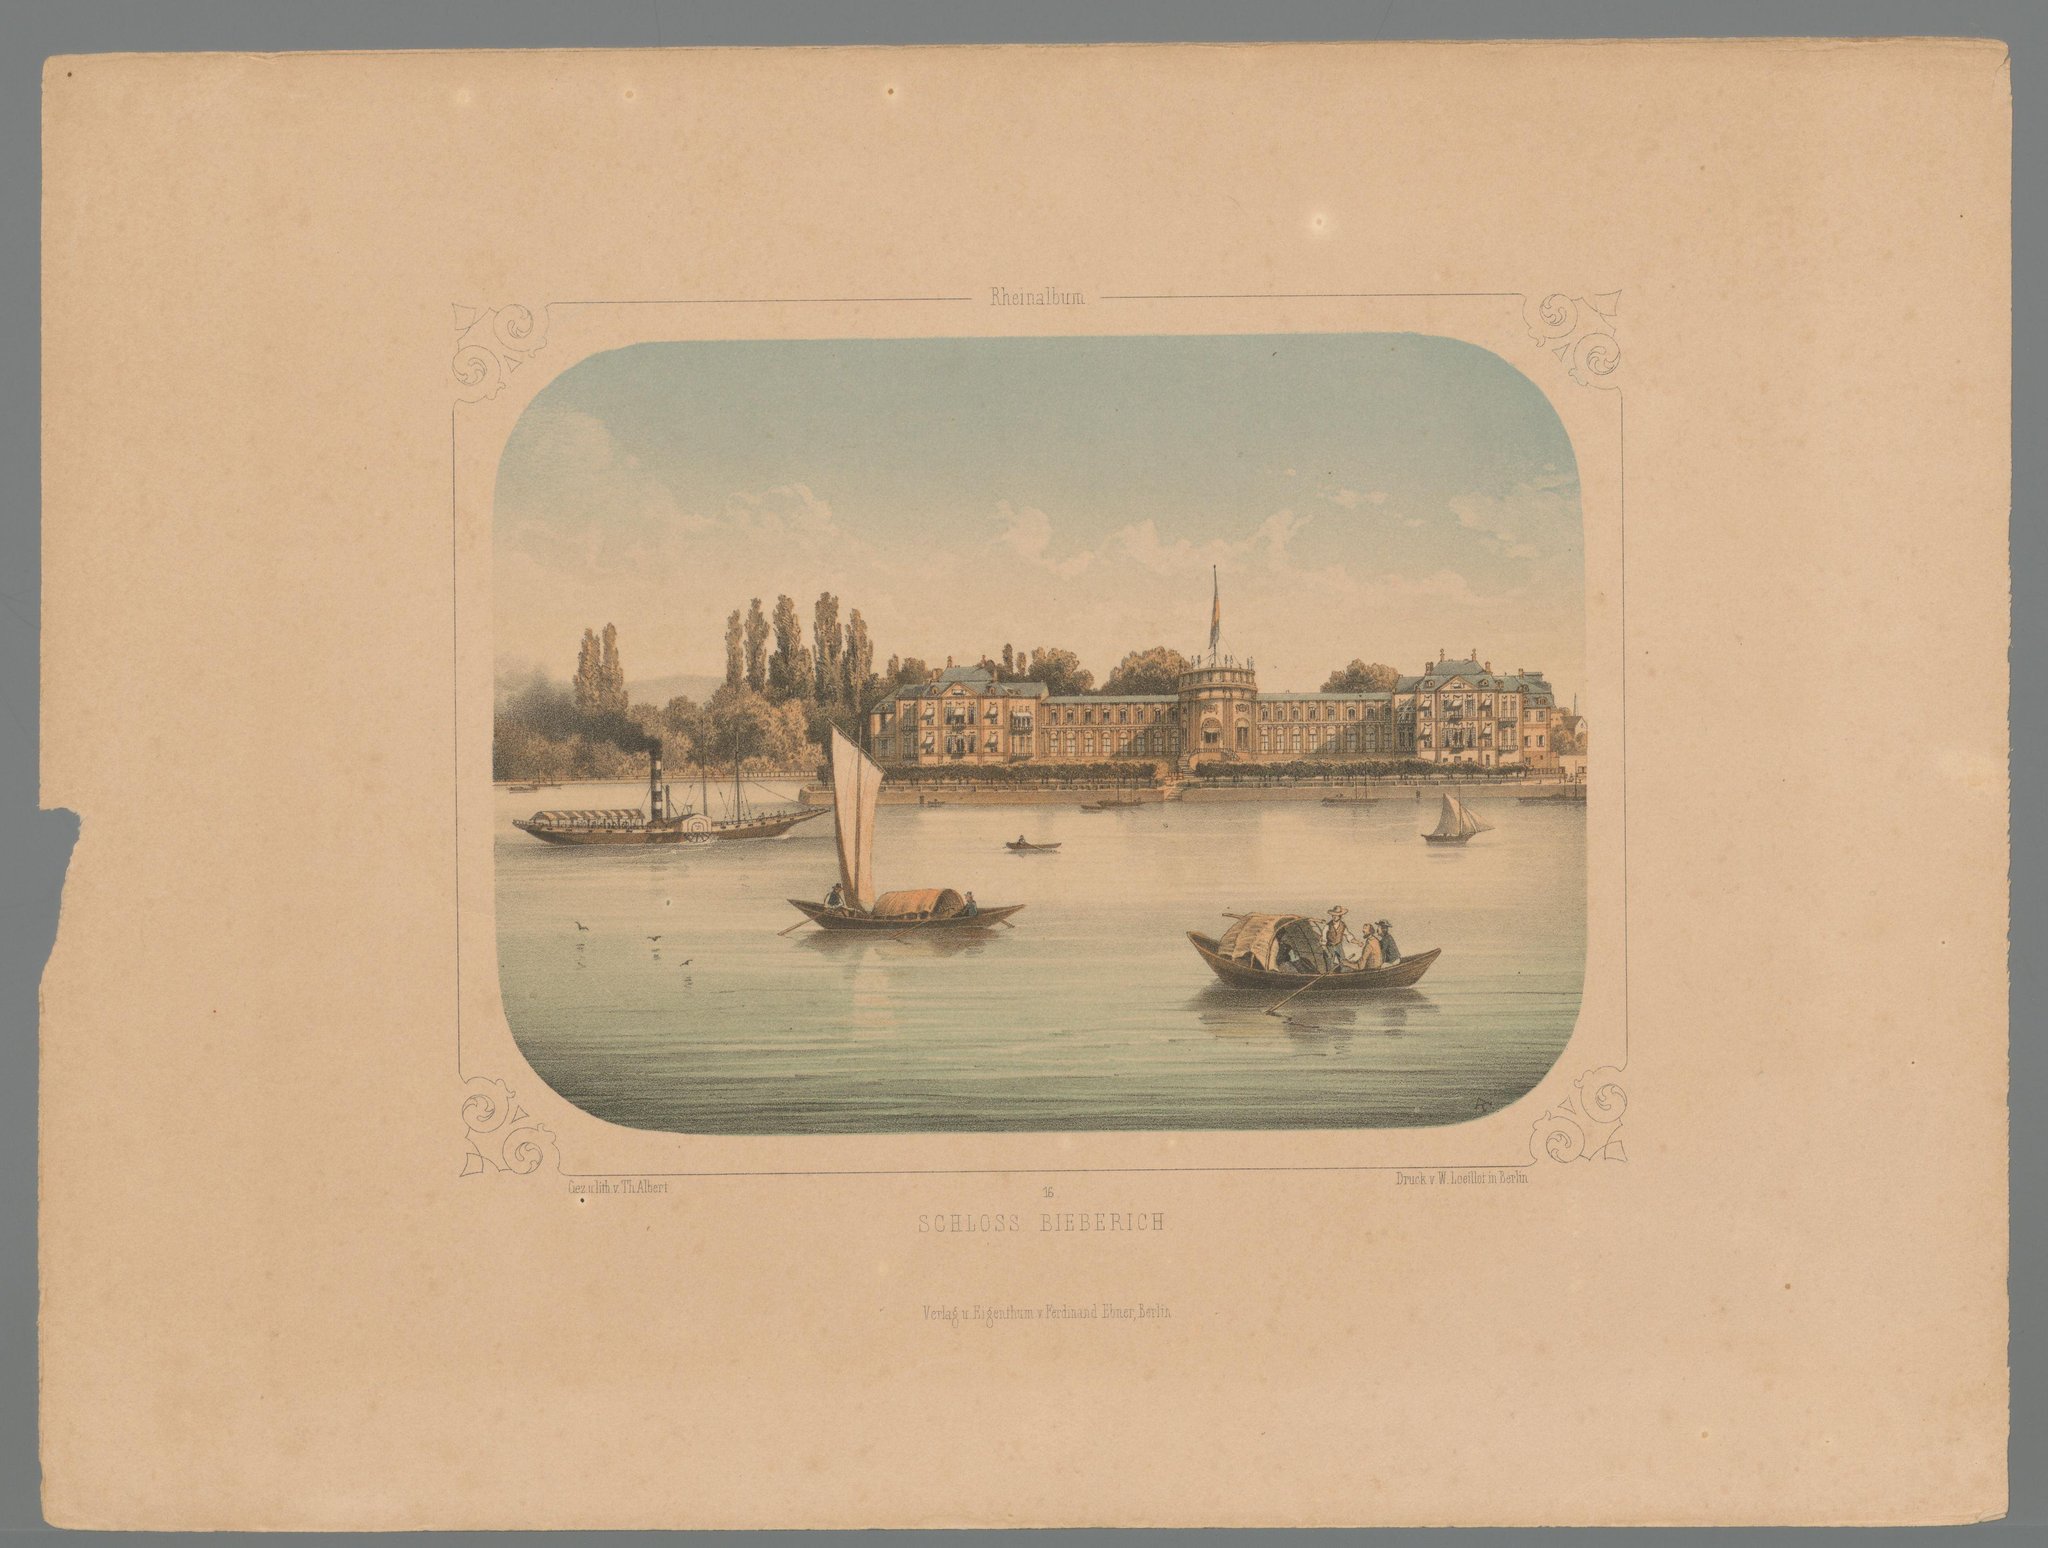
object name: print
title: Gezichten op de Rijn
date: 1858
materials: paper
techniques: lithograph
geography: berlin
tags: river, landscape with tower or castle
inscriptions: collector's mark: Lugt 2228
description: Prent maakt deel uit van een serie van 36 prenten, waarbij het eveneens mogelijk was deze te laten samenbinden tot een album.